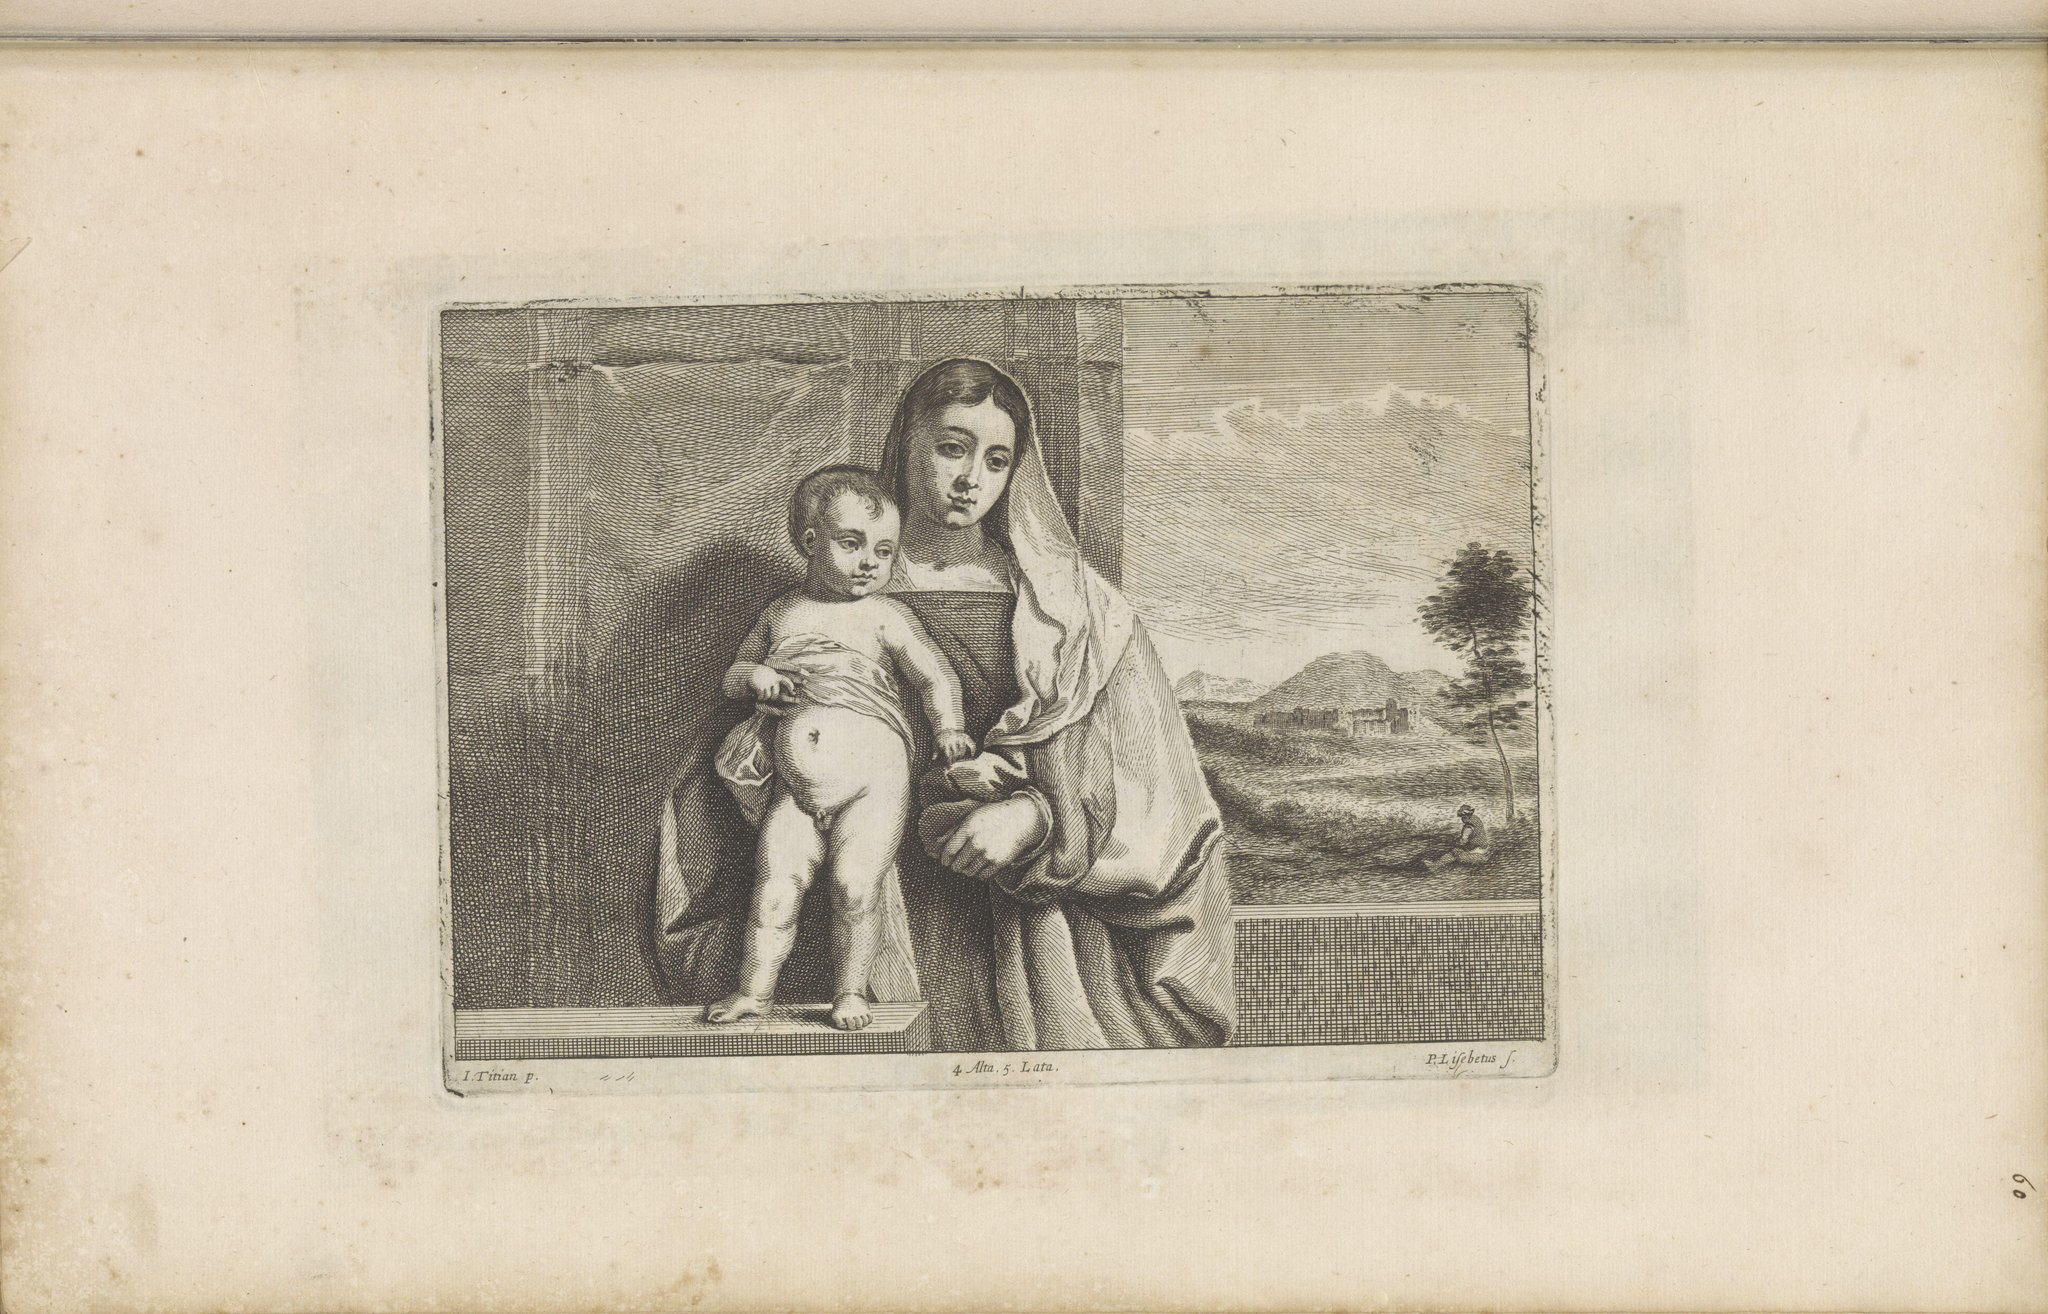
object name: print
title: Maria met het Christuskind voor een muur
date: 1660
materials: paper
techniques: engraving, etching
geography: antwerp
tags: mary standing (or half-length), the christ-child in front of her, close to her bosom; standing, landscapes in the temperate zone, fence, wall, paling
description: De prent is vervaardigd naar een schilderij van Titiaan dat zich in de collectie van het Kunsthistorisches Museum te Wenen bevindt (inventarisnummer 95) en daar getiteld 'Zigeunermadonna'. David Teniers heeft waarschijnlijk van alle schilderijen uit de collectie van Leopold Willem van Oostenrijk een olieverfstudie op doek of paneel vervaardigd (zgn. pasticcio), die als voorbeeld voor de prentmakers diende. Het is niet altijd duidelijk of de pasticci door hem zijn gemaakt of door zijn atelier. Niet alle pasticci zijn overgeleverd.